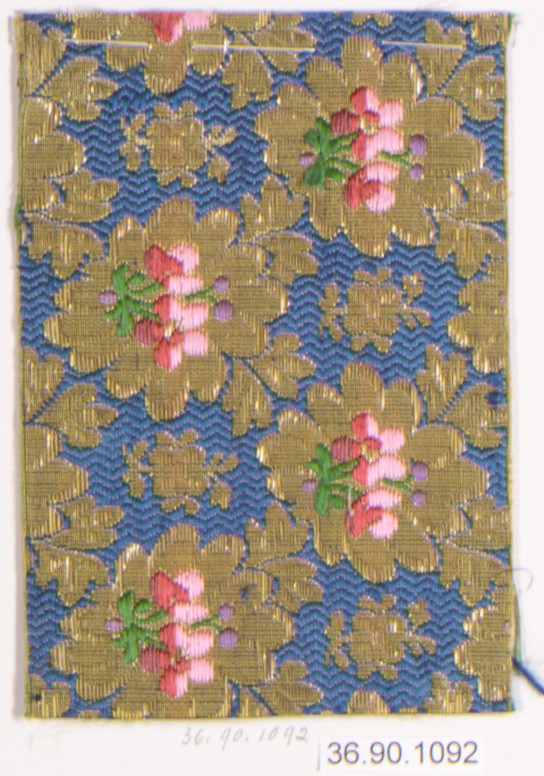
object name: sample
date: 1701-1900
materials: metal thread, silk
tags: flowers